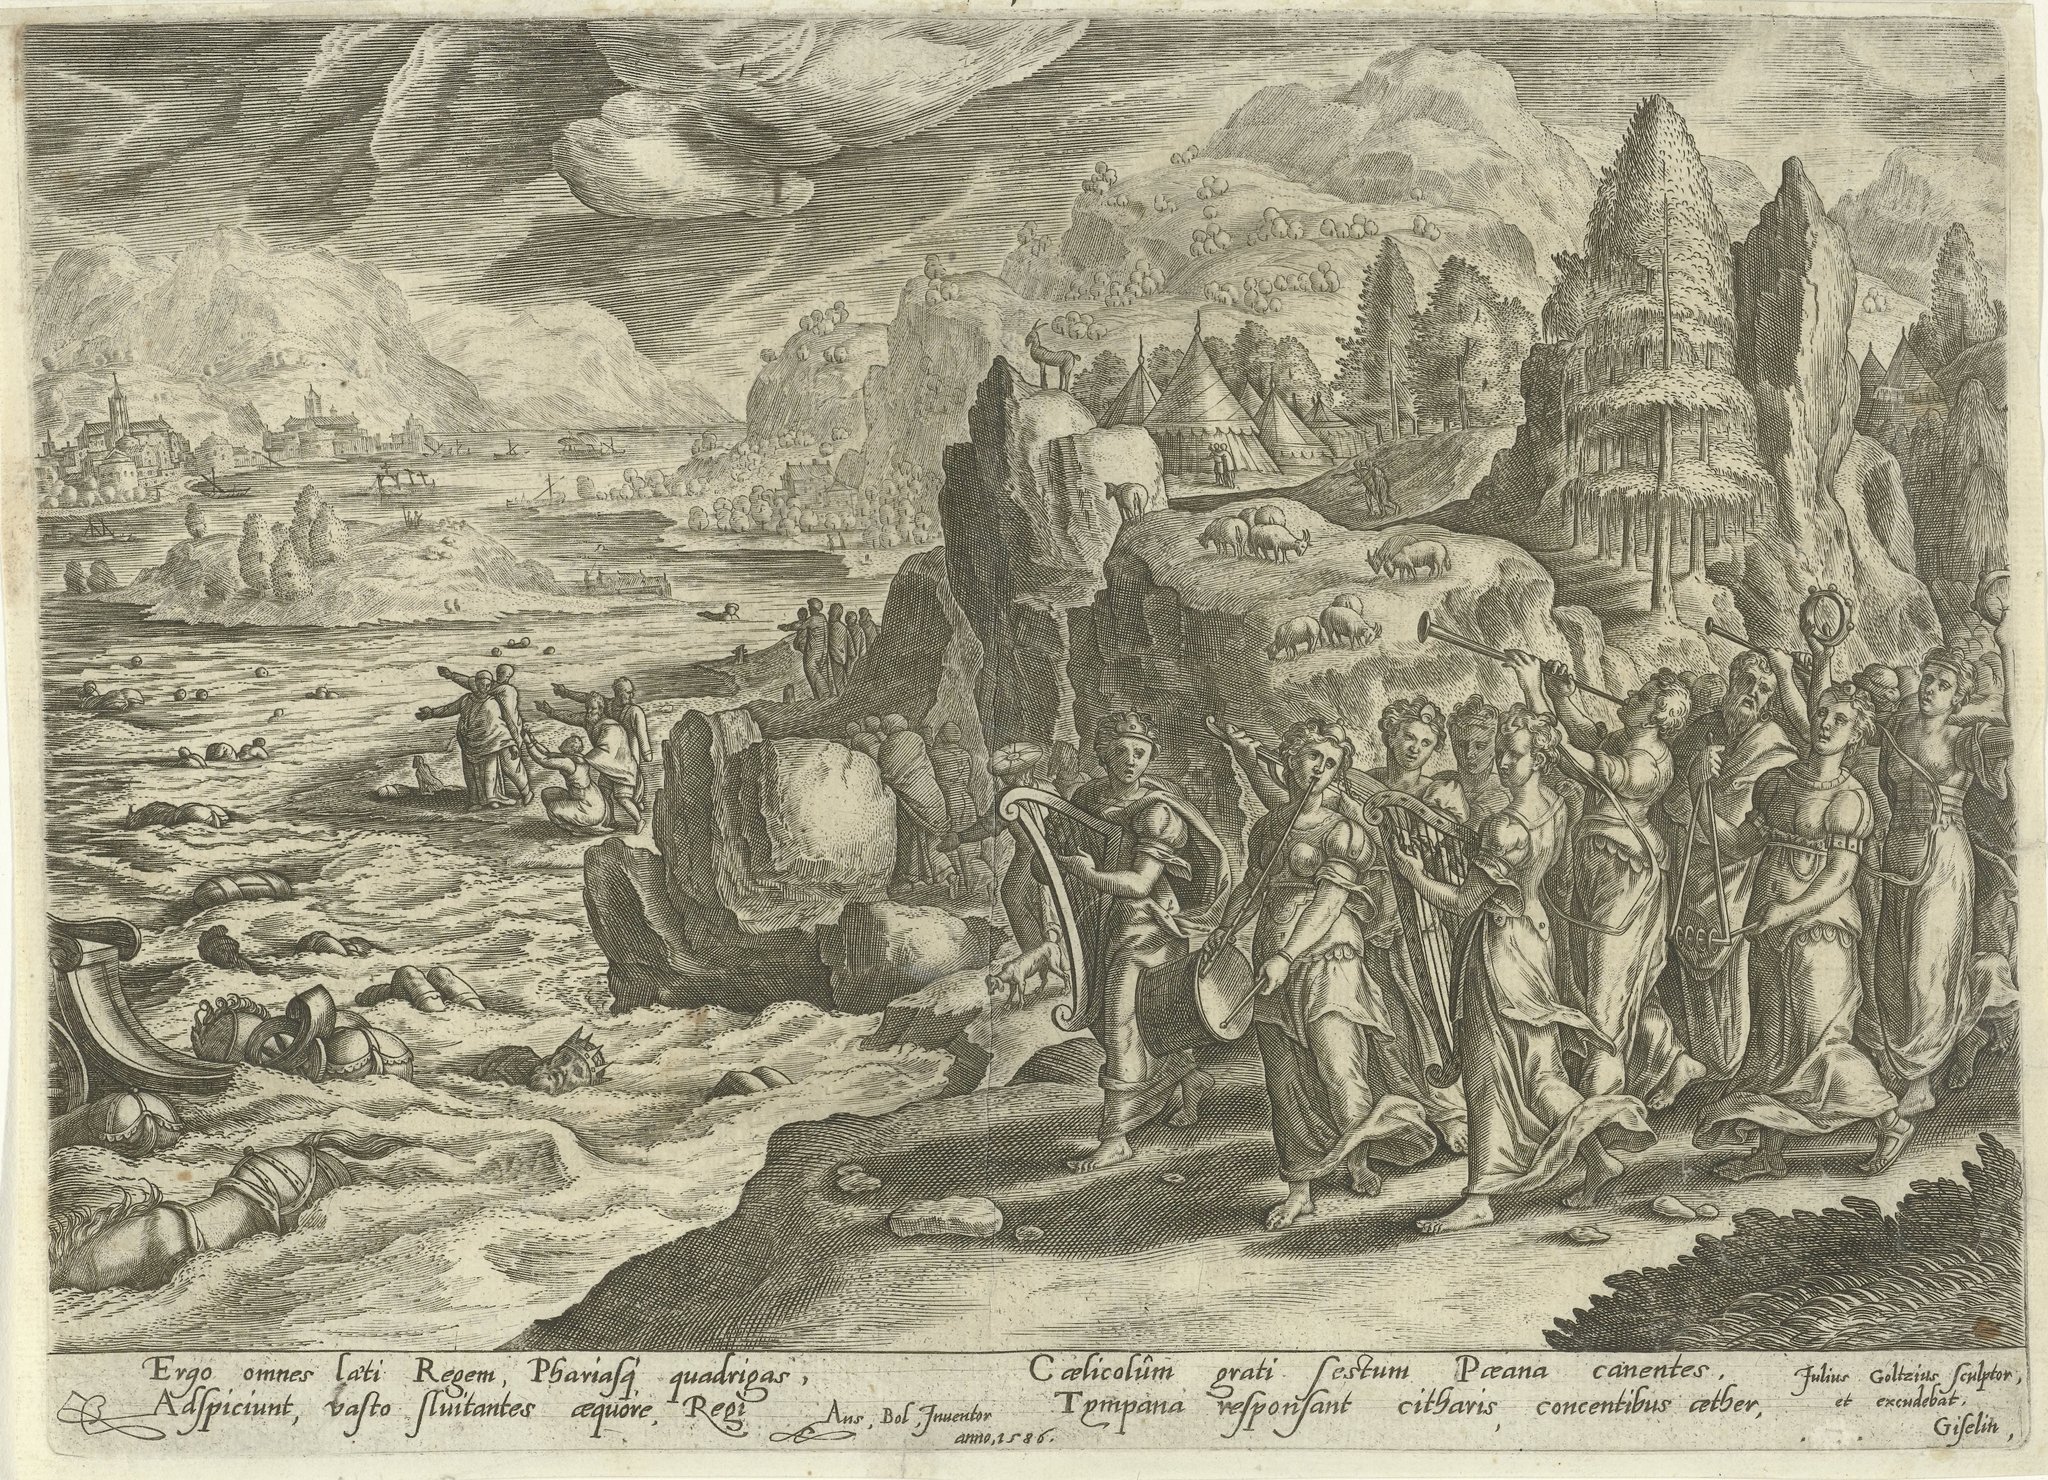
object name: print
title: Viering van de ondergang van het Egyptische leger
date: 1586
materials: paper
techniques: engraving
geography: antwerp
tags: miriam takes up a tambourine and dances; all the women follow her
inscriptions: collector's mark: Lugt 2228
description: Het Egyptische leger verdrinkt in de Rode Zee. Op de voorgrond vieren de profetes Mirjam en een stoet vrouwen met muziekinstrumenten de overwinning. Op de achtergrond danken de Israëlieten God. De prent heeft een Latijns onderschrift en maakt deel uit van een serie over de vlucht uit Egypte.